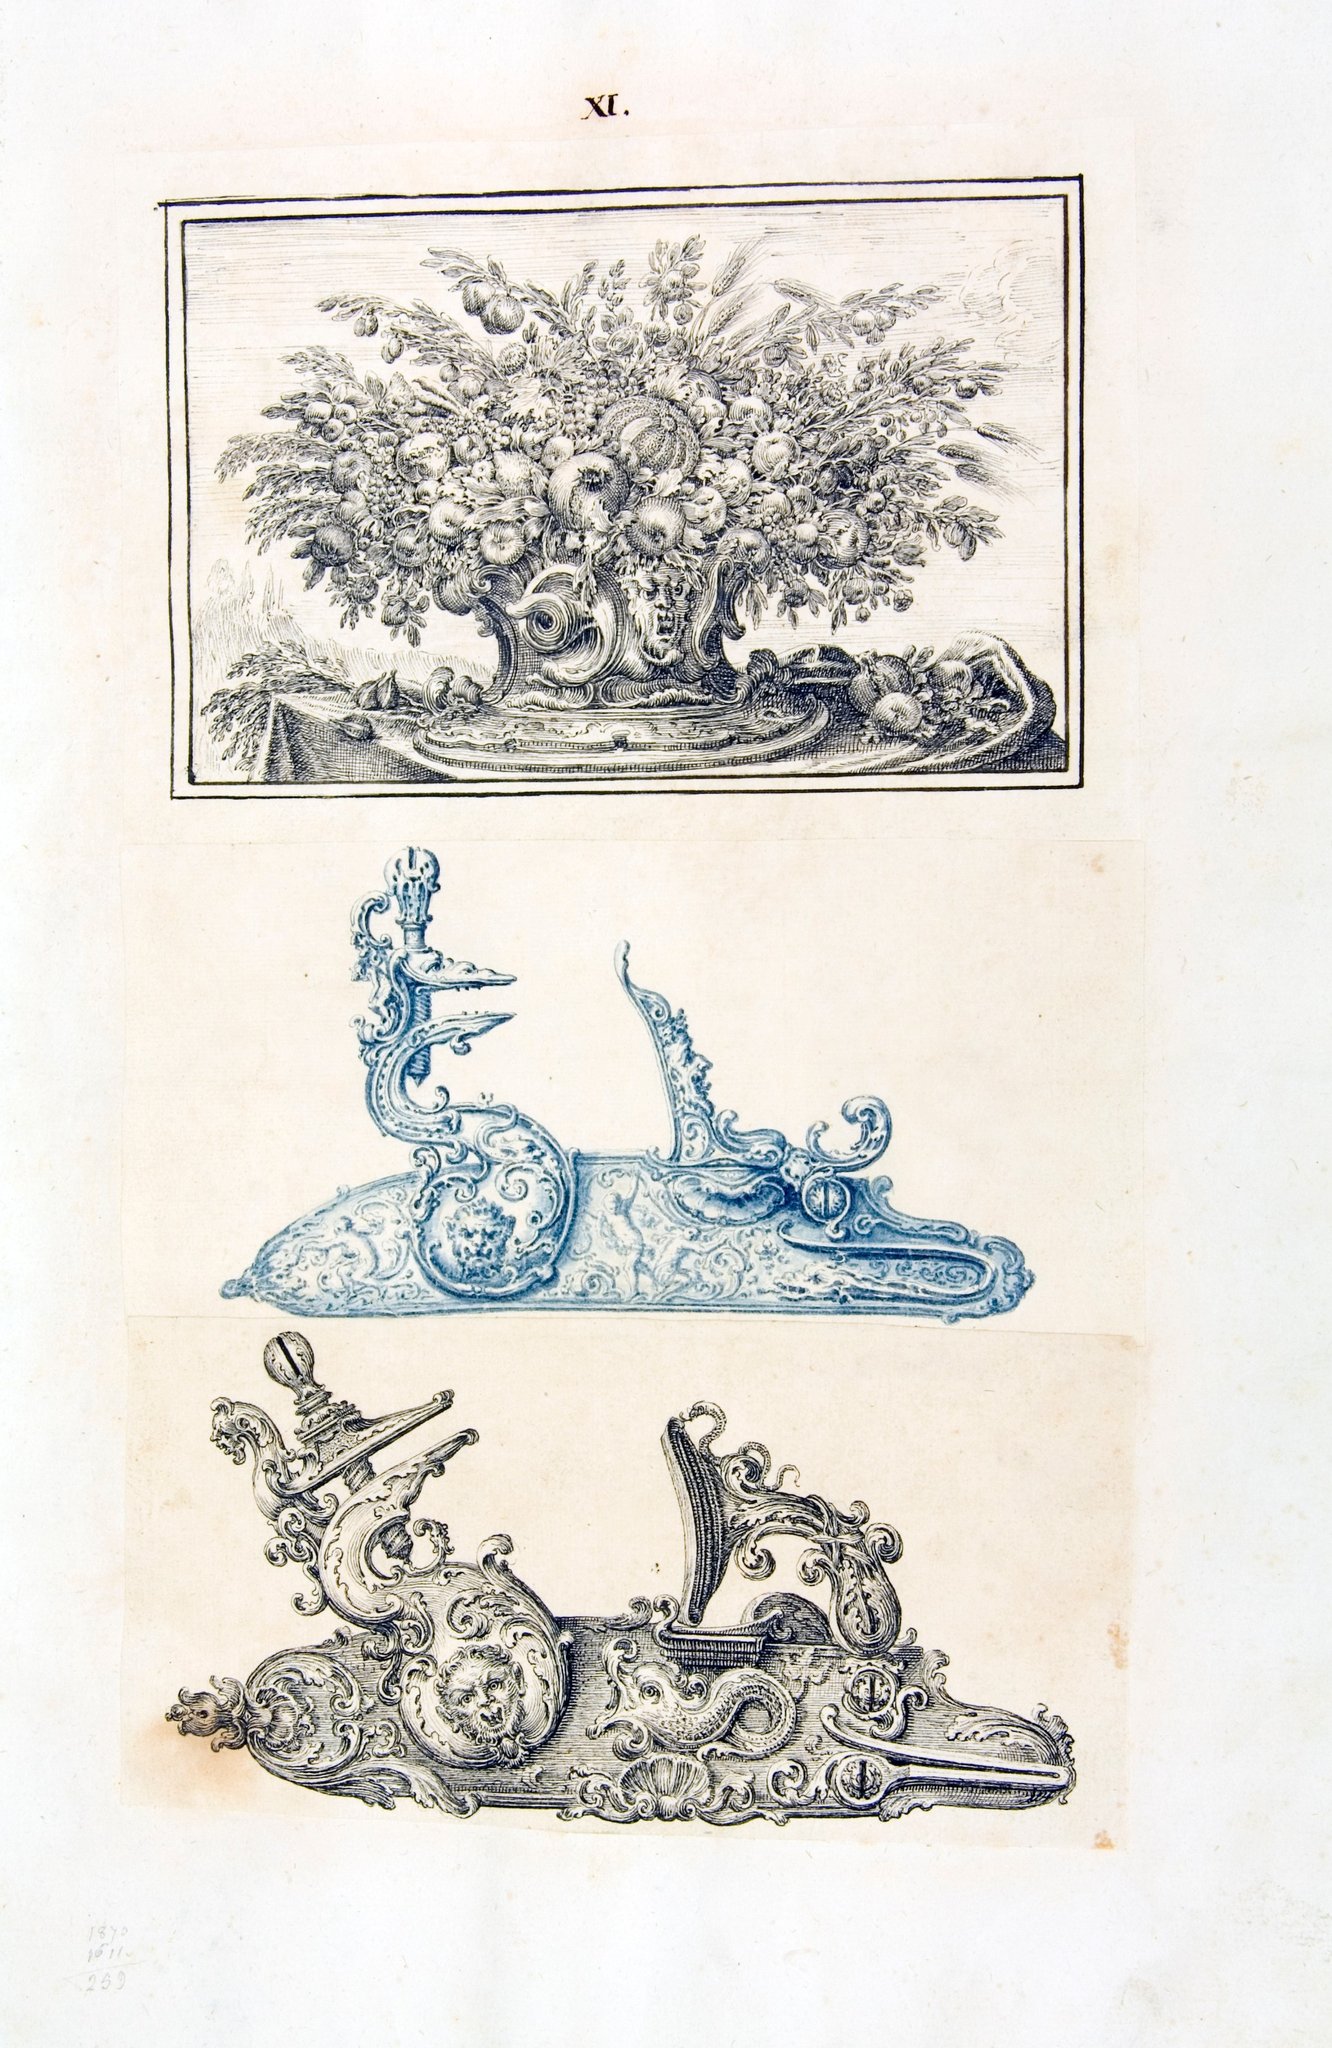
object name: drawing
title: Album Page with Designs for Floral Ornament and Two Gunlocks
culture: french or italian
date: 1701-1800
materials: ink, paper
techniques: pen, wash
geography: france or italy